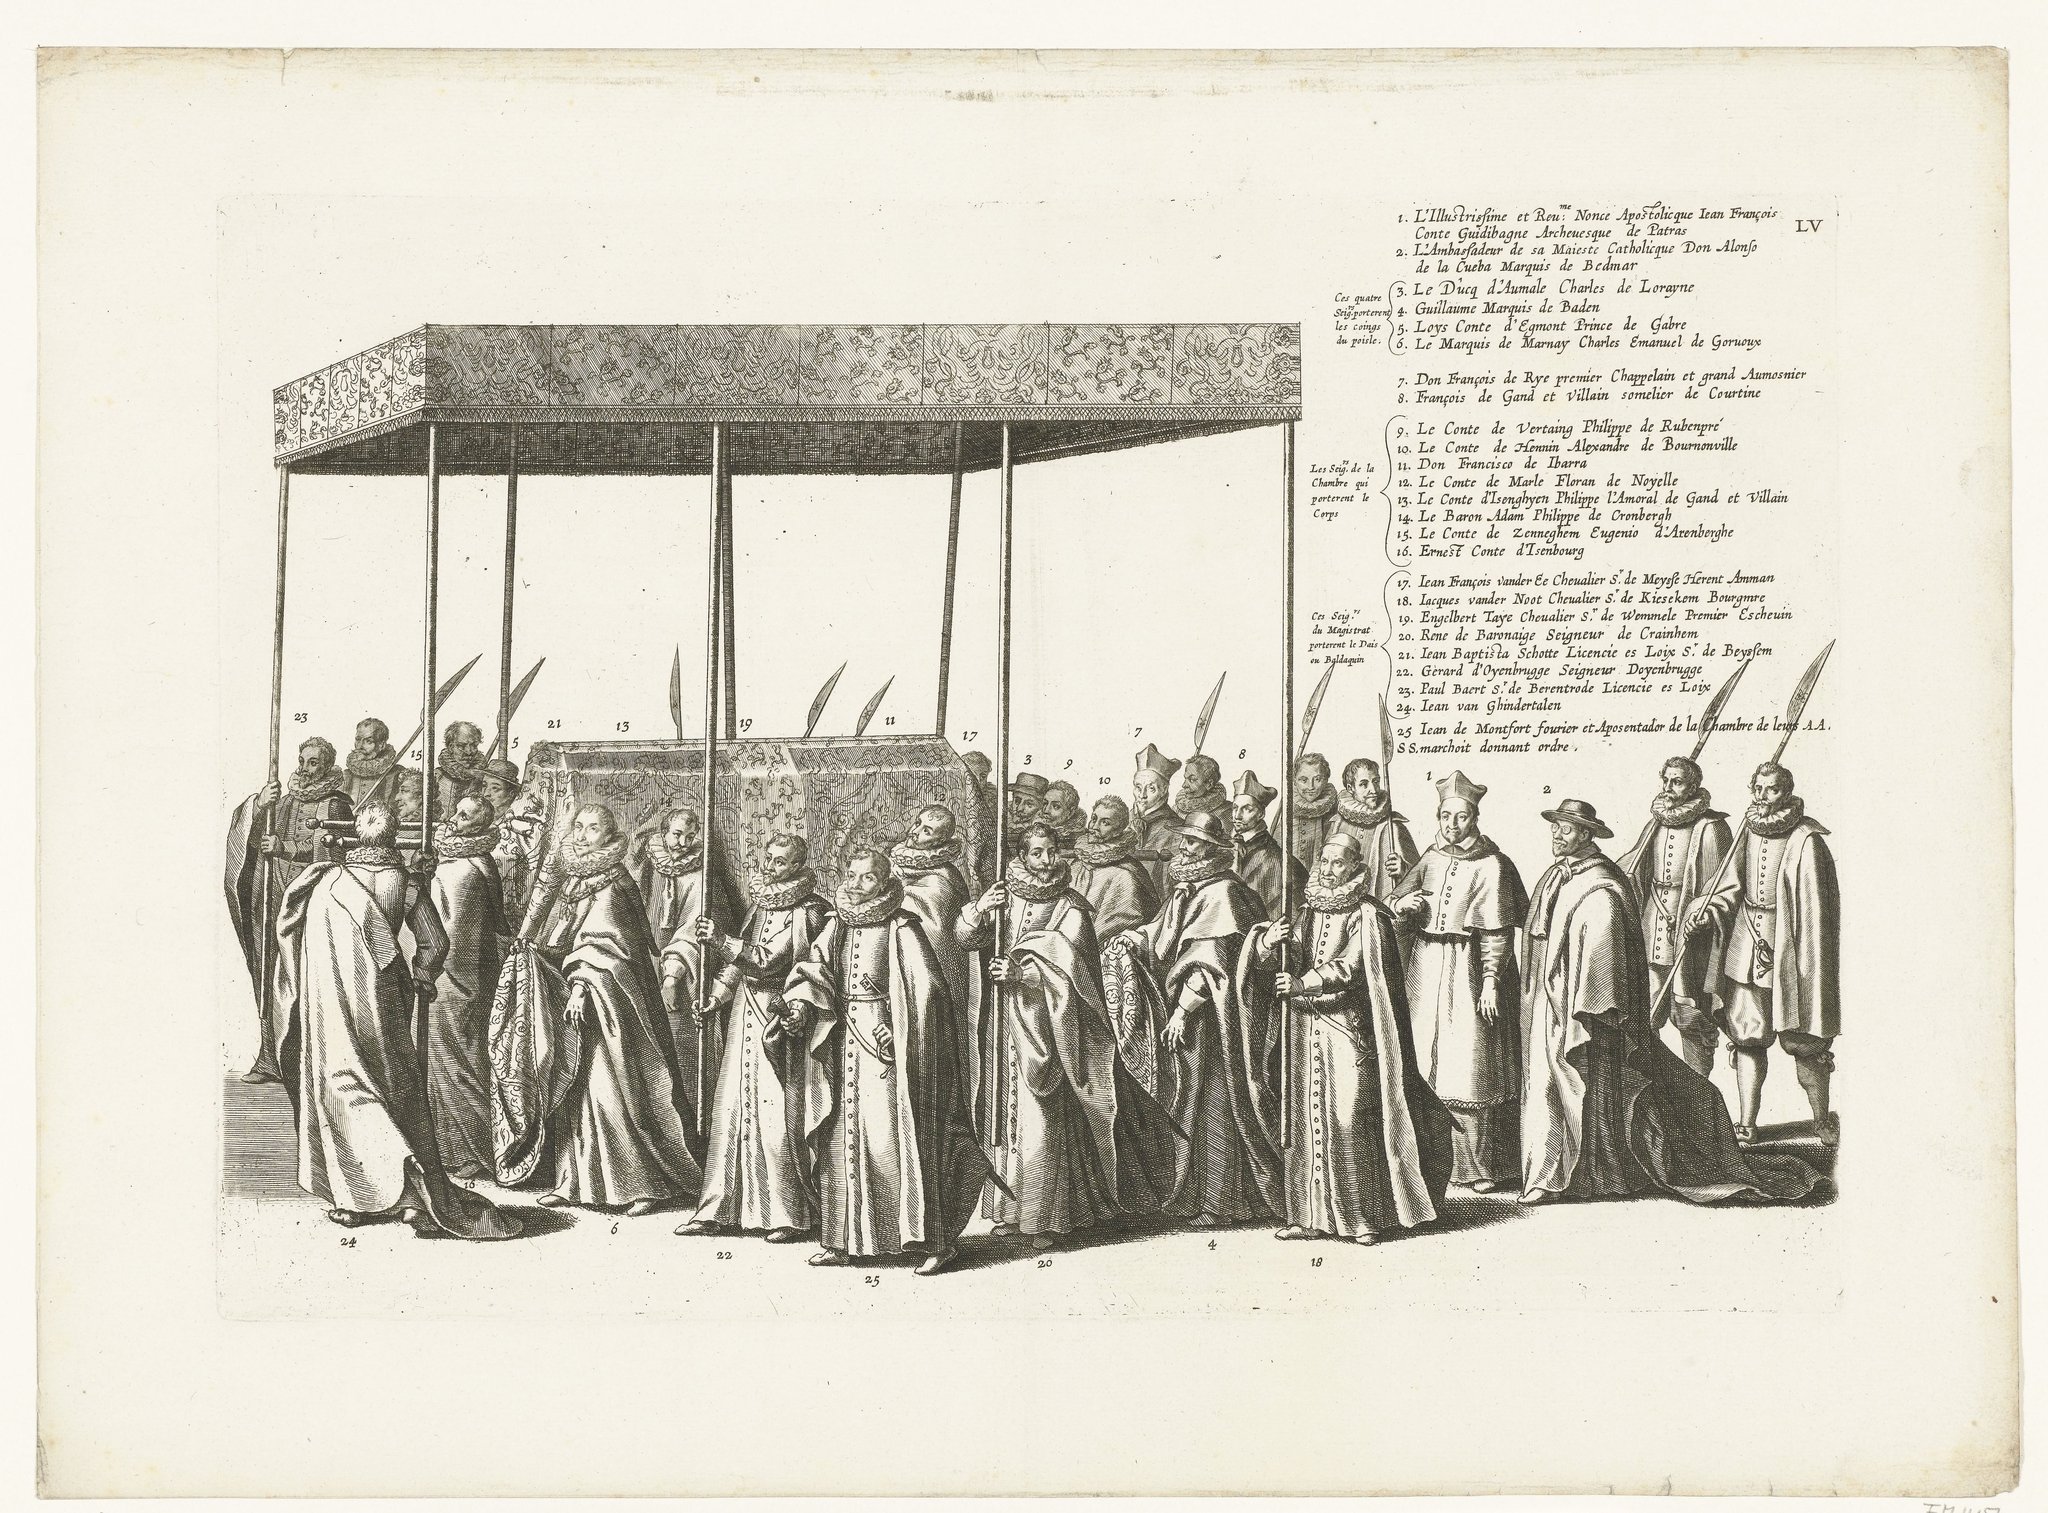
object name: print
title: Begrafenis van aartshertog Albrecht, 1622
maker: cornelis galle (i)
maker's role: print maker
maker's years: 1576-1650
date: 1623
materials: paper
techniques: etching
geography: southern netherlands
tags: brussels, albrecht aartshertog van oostenrijk, litter, coffin rest, cortege, funeral procession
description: De doodskist gedragen onder een baldakijn in de begrafenisstoet. Rechts een lijst van de dragers in het Frans 1-26. Plaat LV in de serie van de begrafenis van aartshertog Albrecht van Oostenrijk te Brussel op 12 maart 1622.